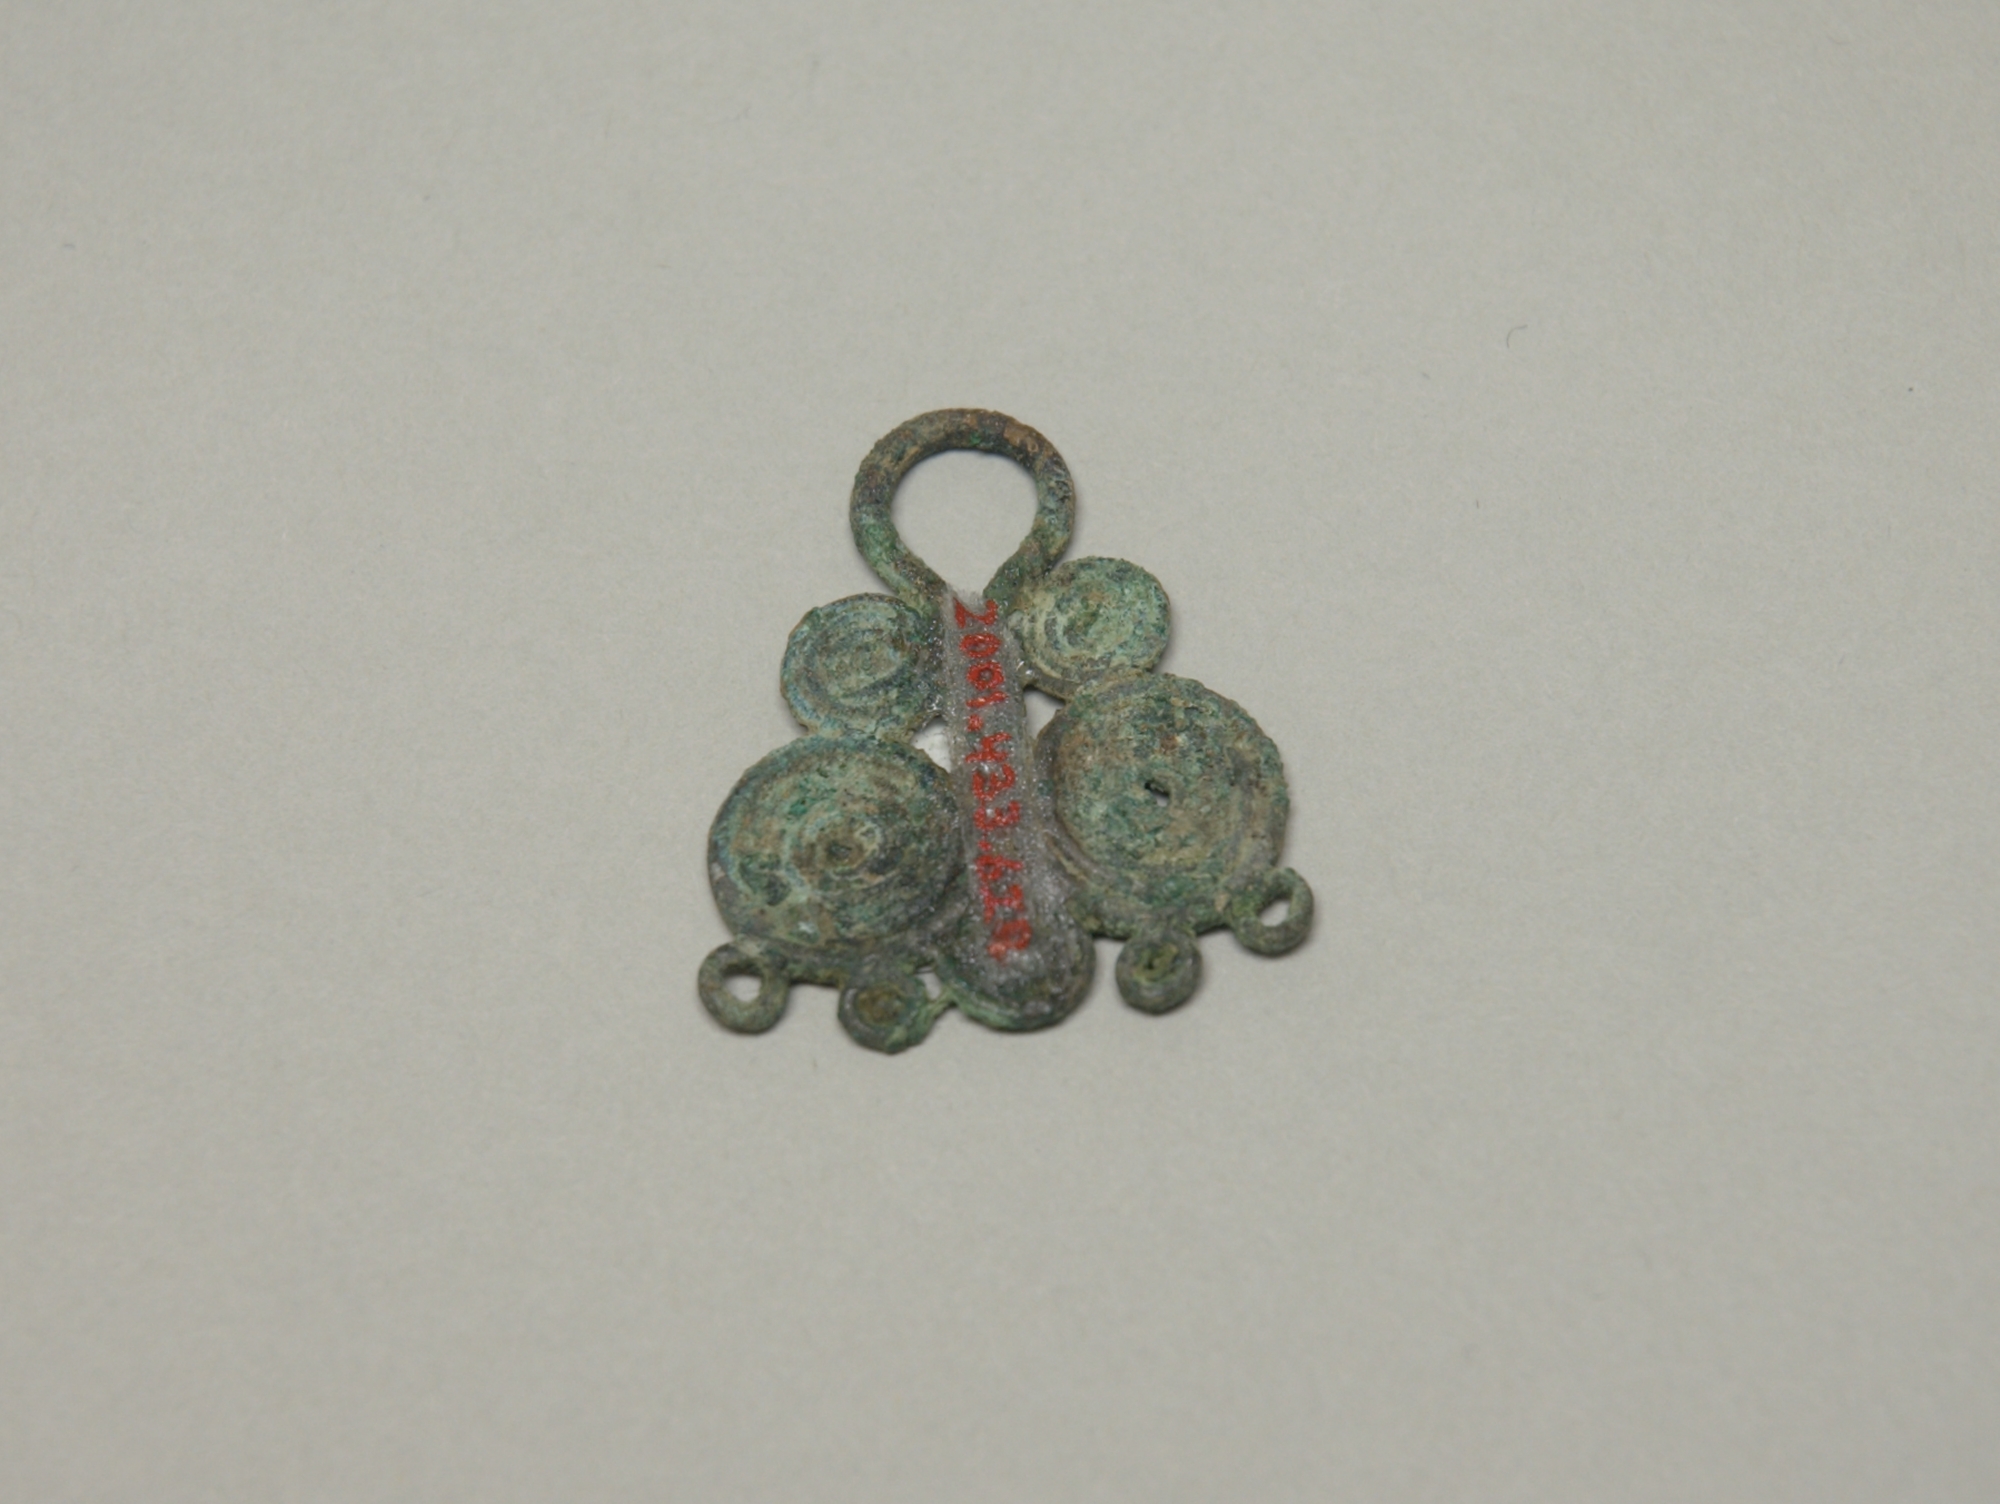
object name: pendant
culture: indonesian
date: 500 BCE-300 CE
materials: bronze